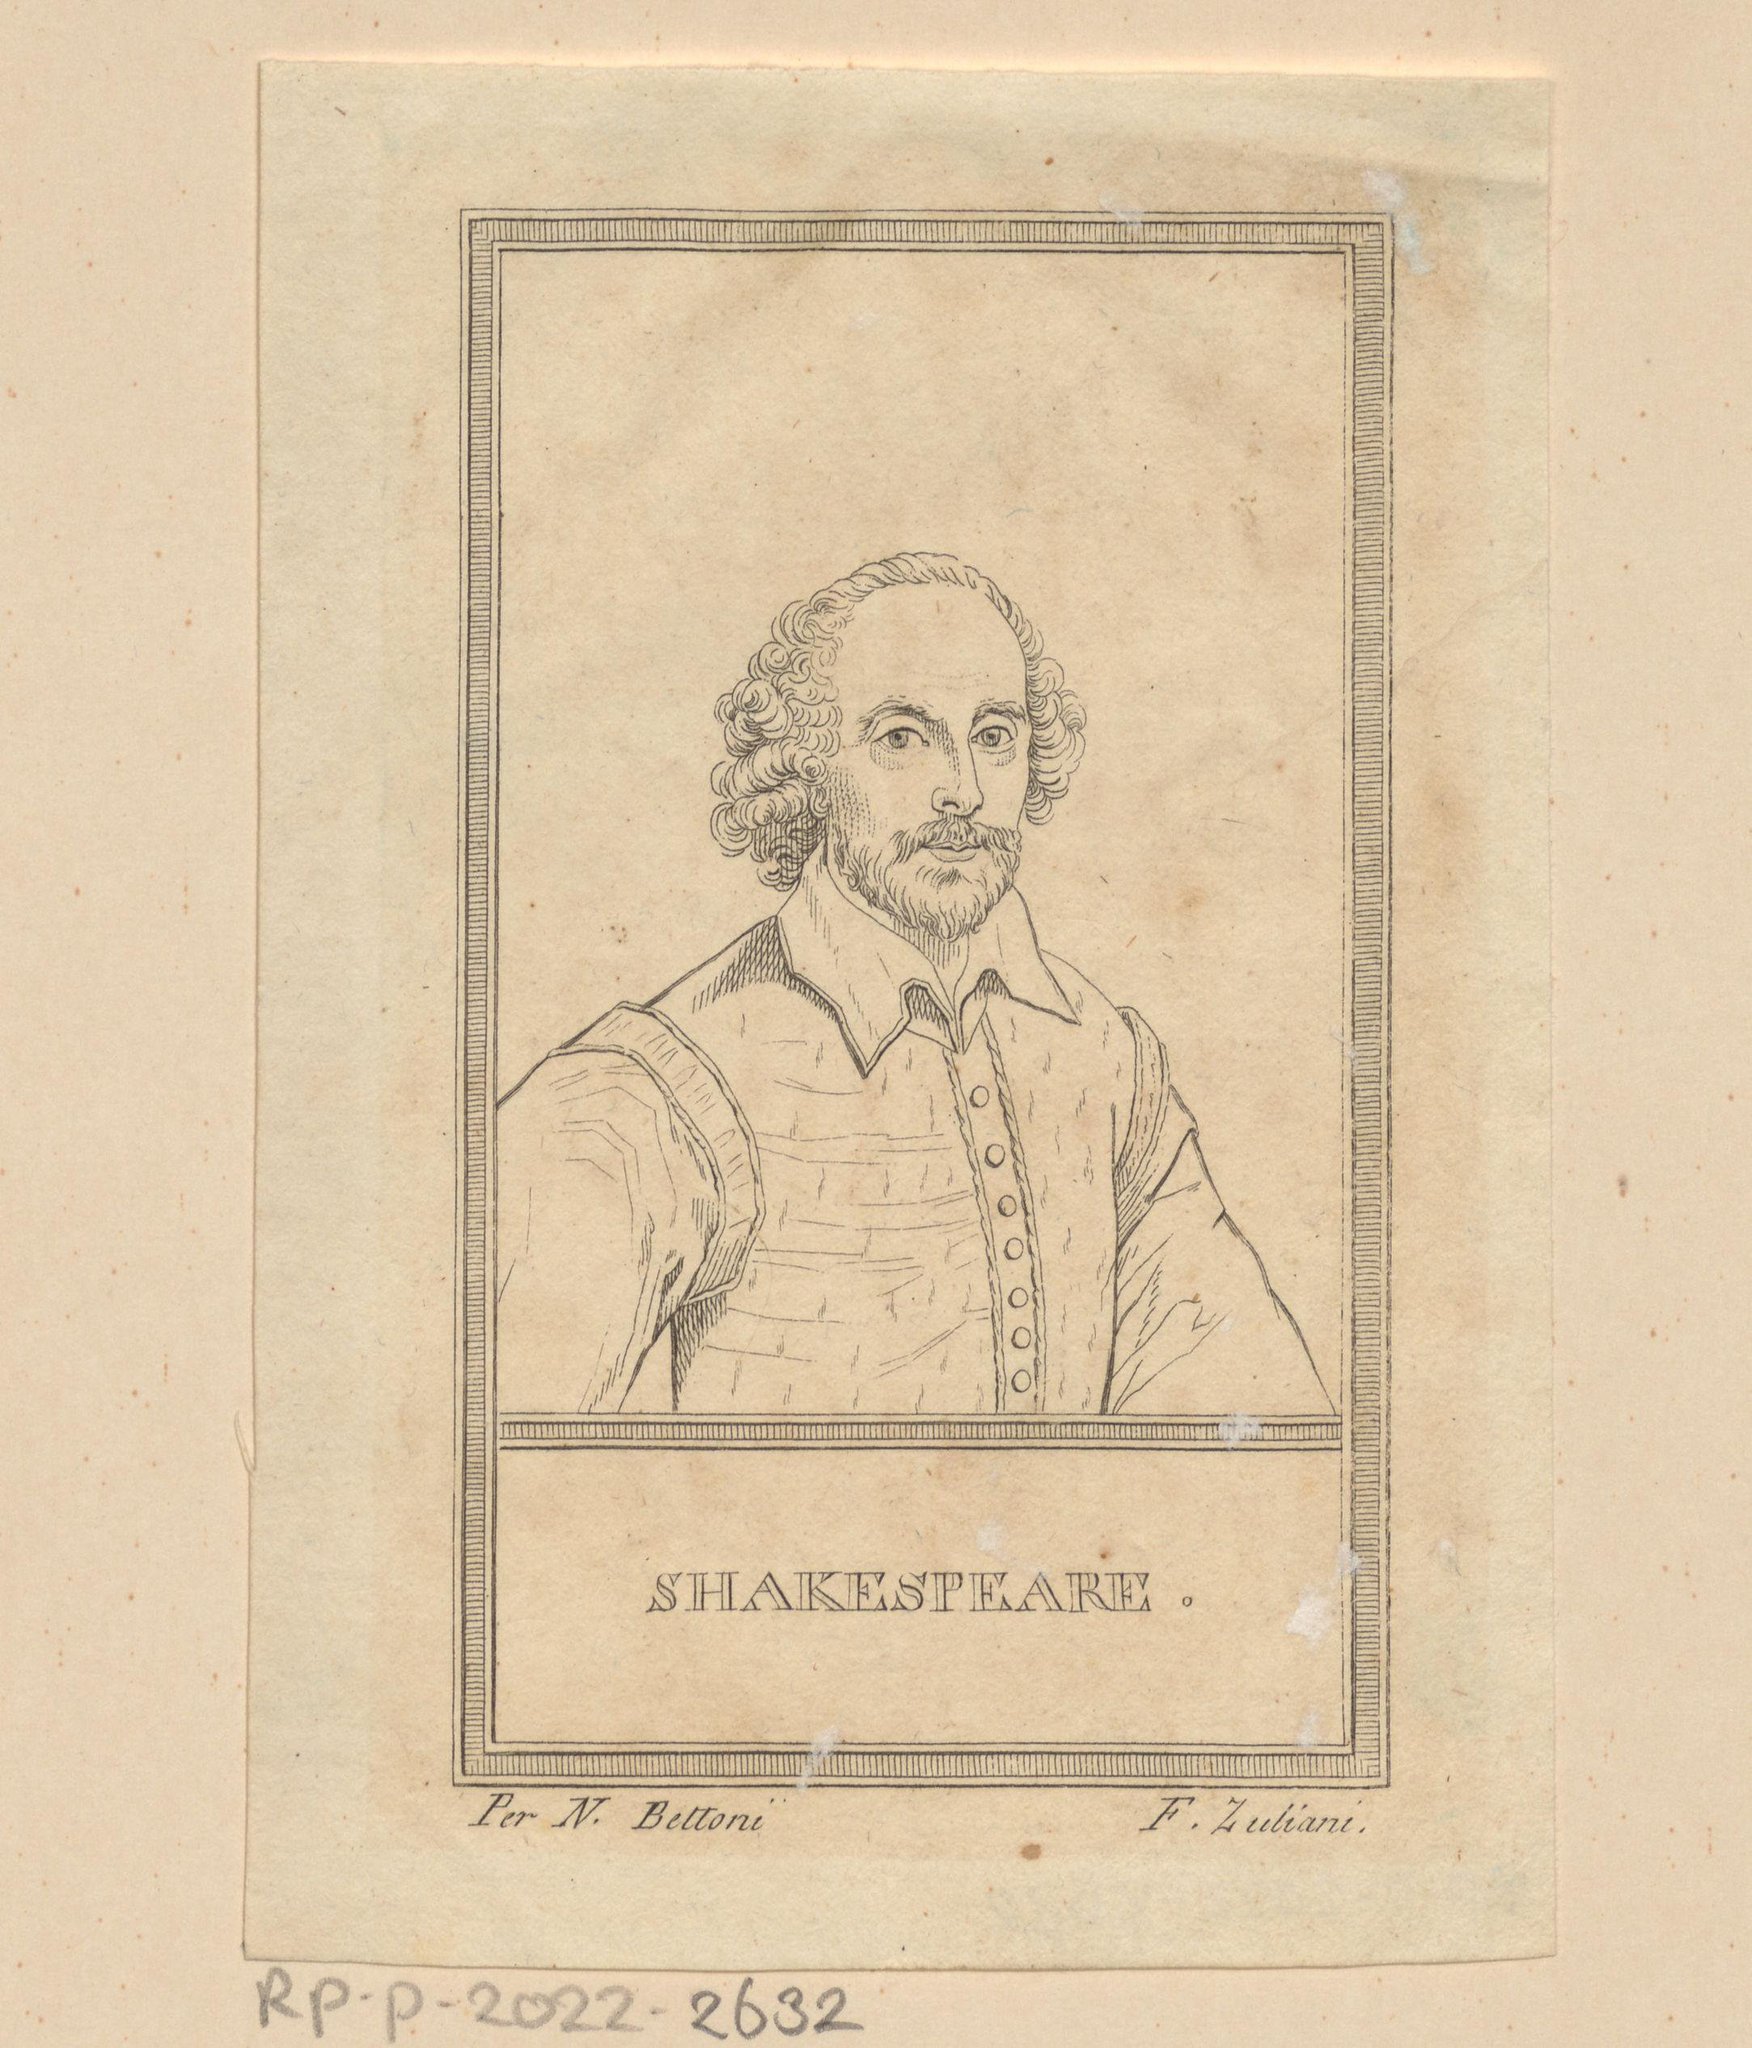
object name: print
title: Portret van William Shakespeare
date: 1822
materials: paper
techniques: etching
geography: italy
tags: william shakespeare, historical persons, portrait of a writer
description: Prent waarschijnlijk uit: Galerie choisie d'hommes célèbres de tous les tems et de toutes les nations. Amsterdam: Pino, T.L., 1822, dl. 1.